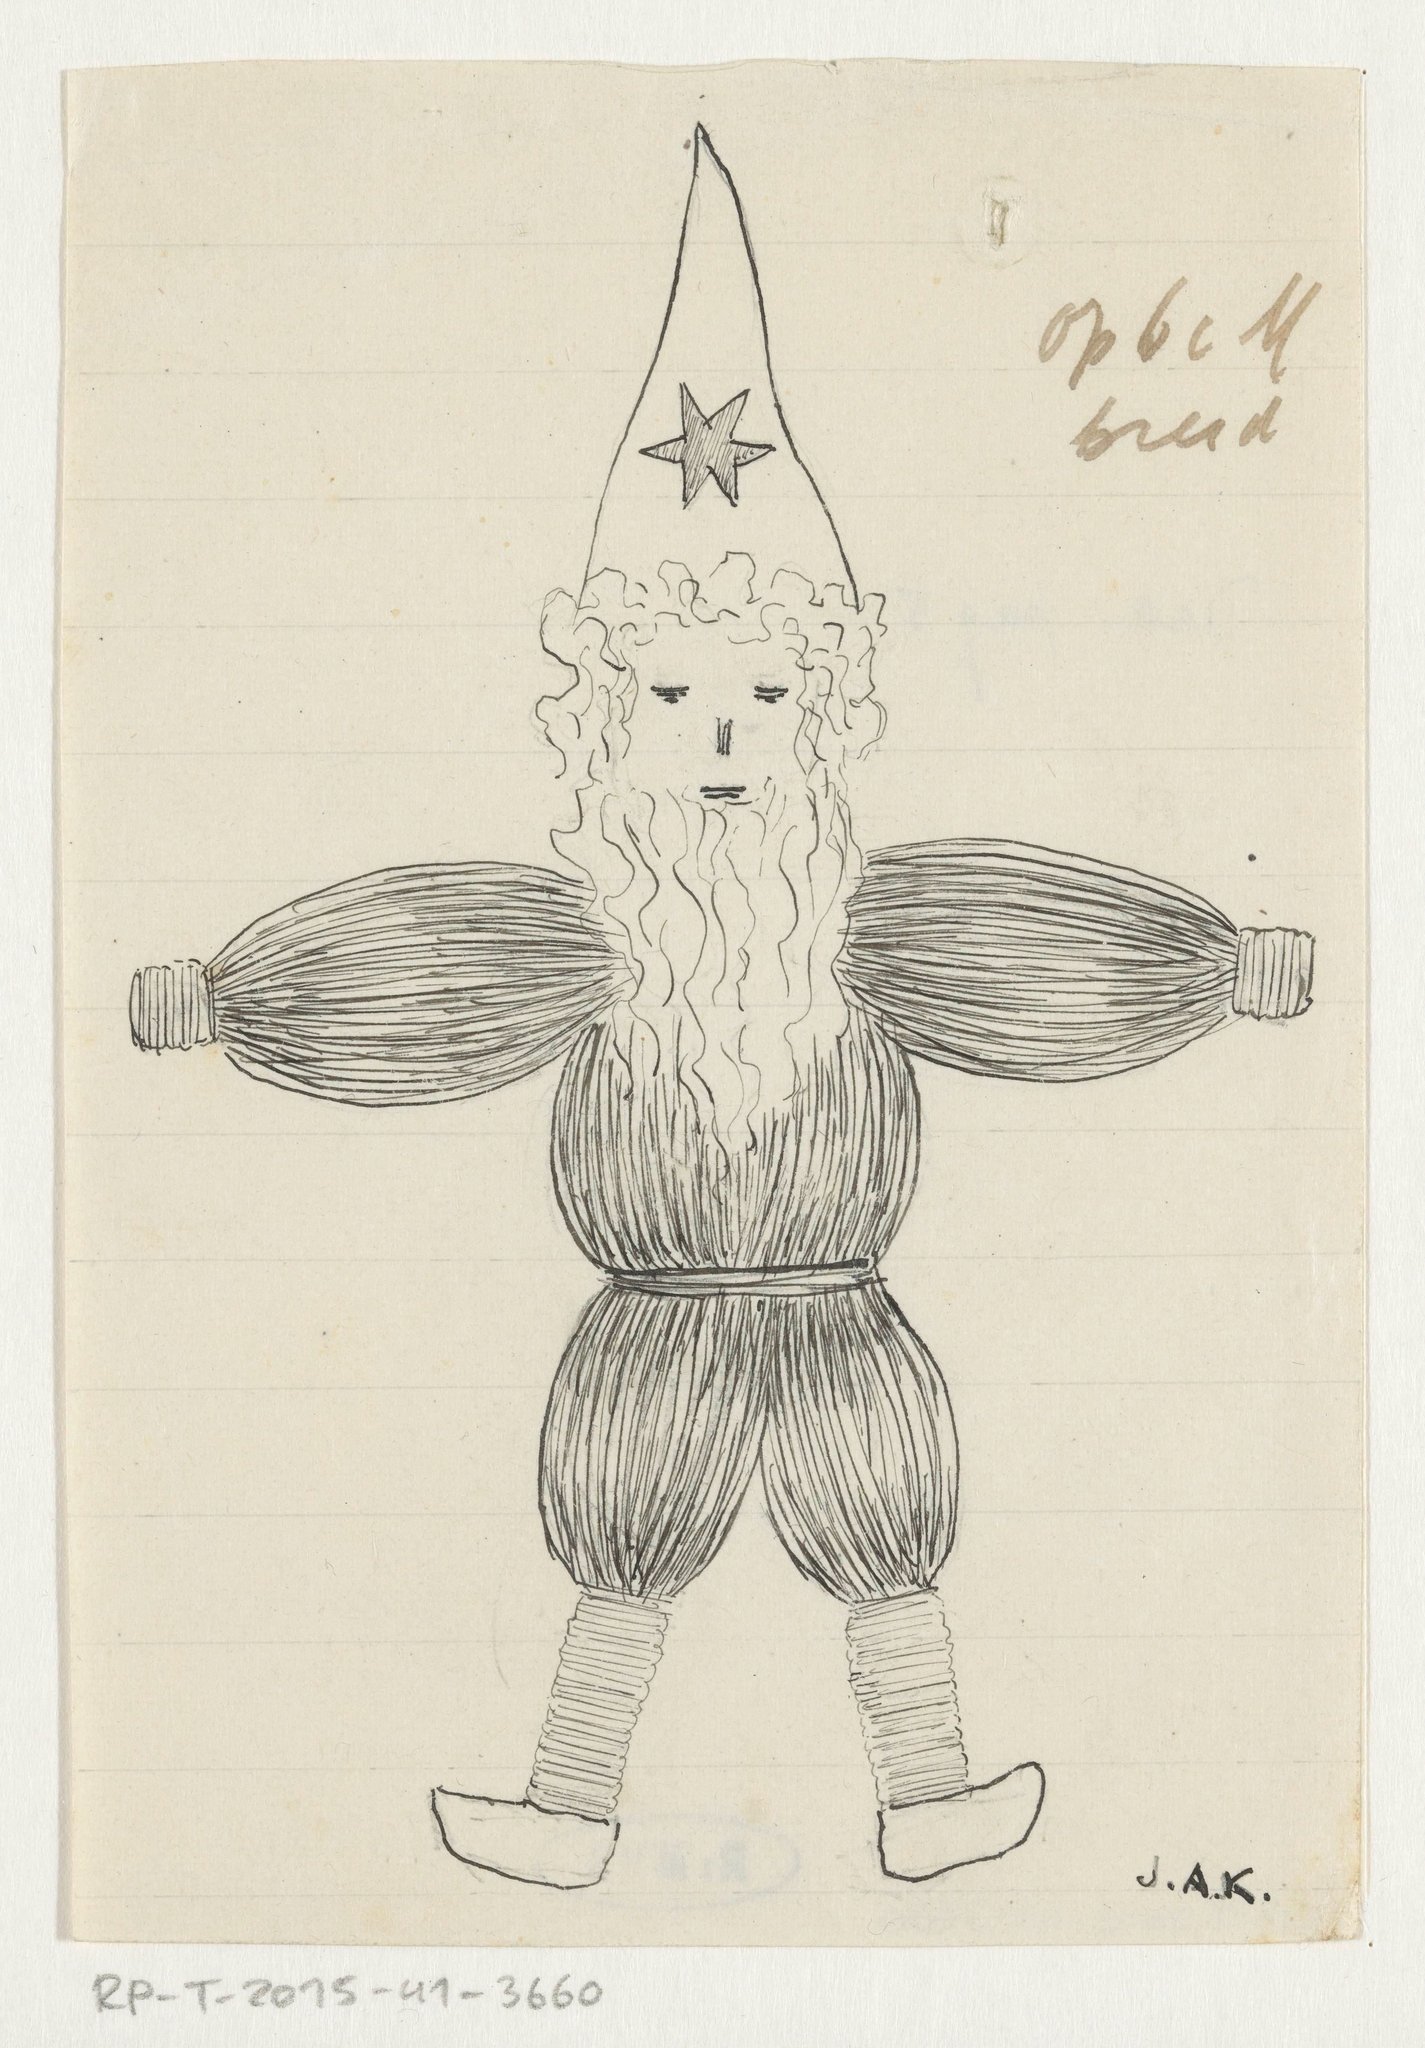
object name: drawing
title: Pop met baard en puntmuts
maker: Anonymous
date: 1880-1930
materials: ink, pencil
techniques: pen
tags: (playing with) dolls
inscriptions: signature: ‘J.A.K.’, collector's mark: Lugt 2228a, annotation: ‘Dec. pag 5’, :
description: Lappenpop met uitgestrekte armen en benen, een baard en een puntmuts met een ster.